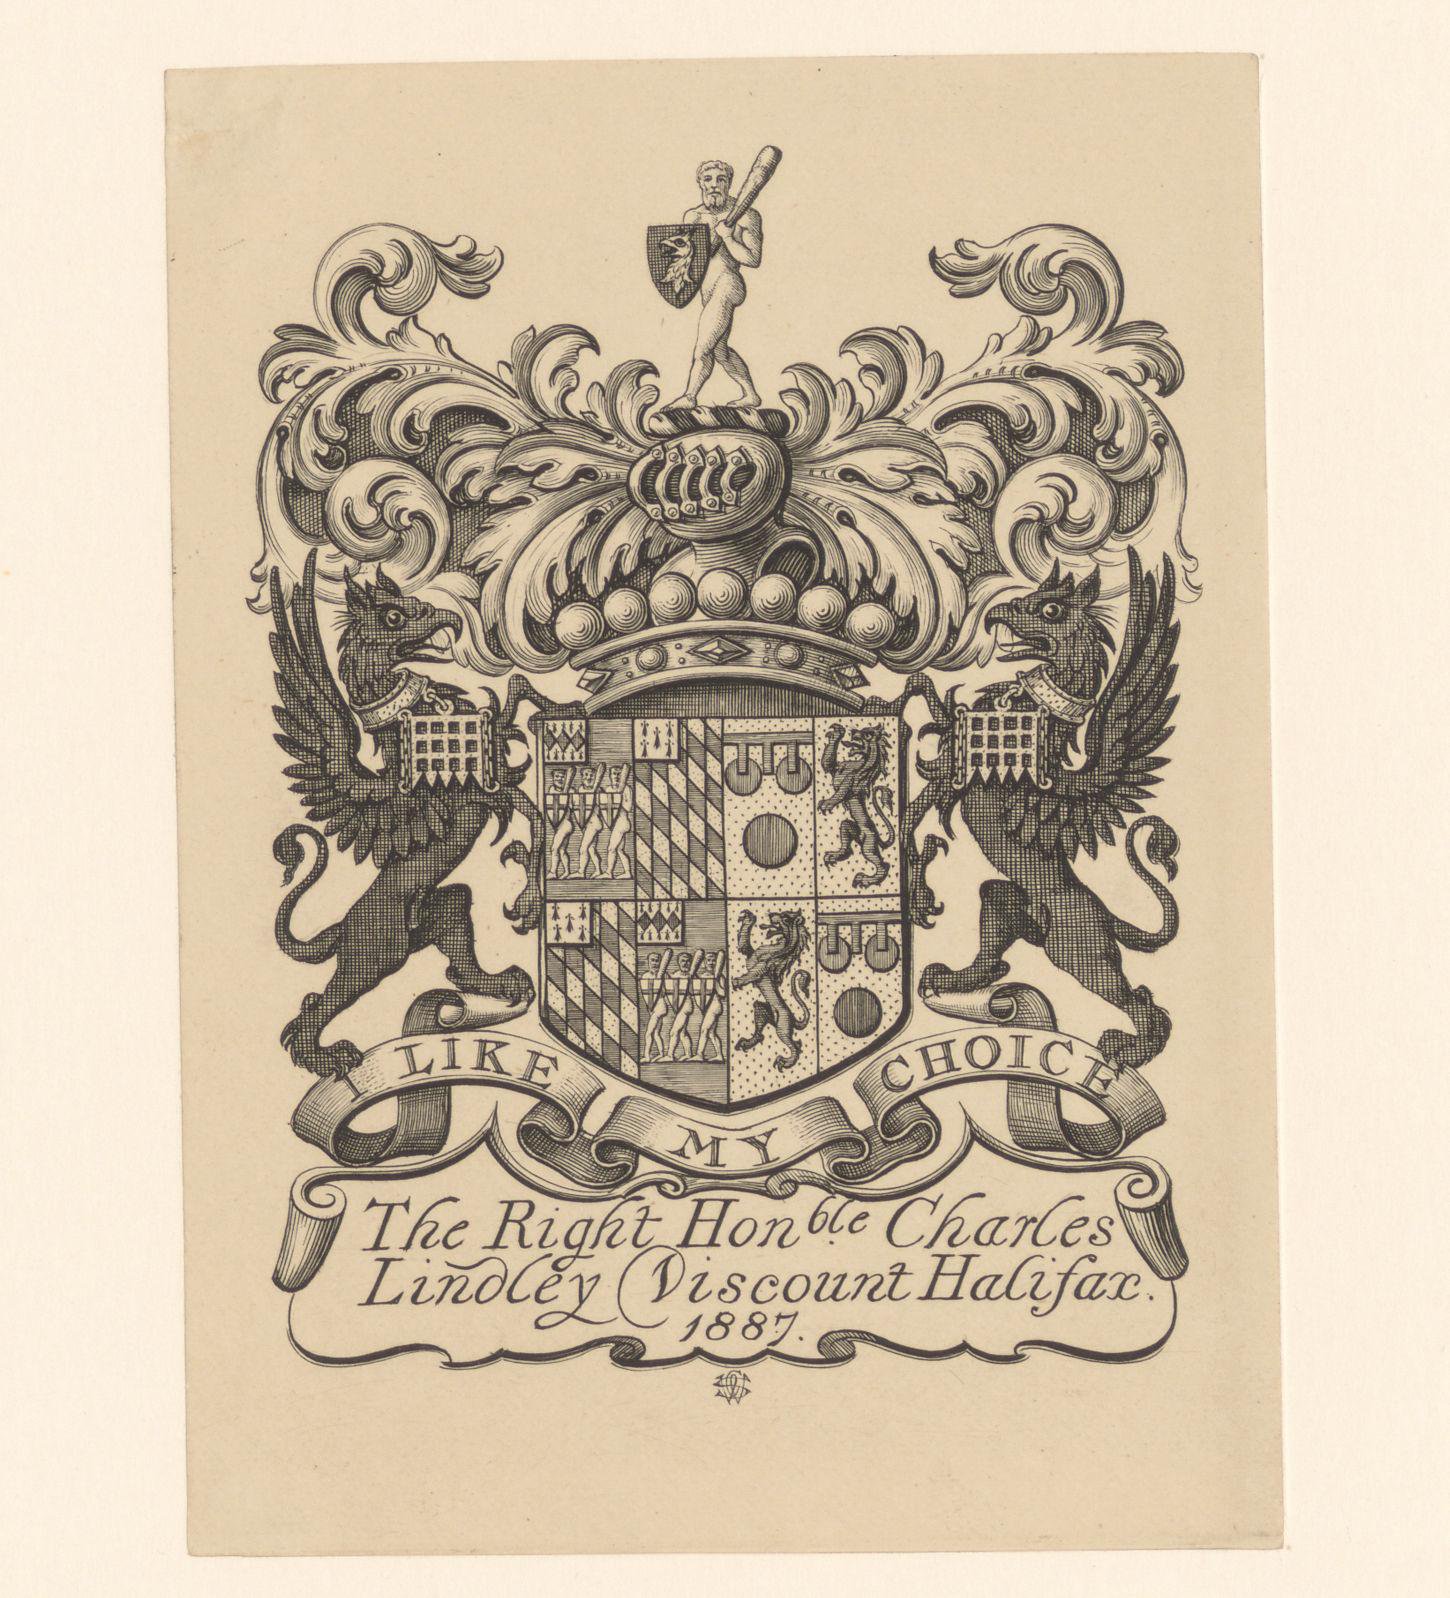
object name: bookplate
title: Ex libris van Charles Lindley Wood, burggraaf van Halifax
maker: charles william sherborn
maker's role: print maker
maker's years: 1831-1912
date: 1887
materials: paper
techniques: engraving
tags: foliage ~ ornament, siren (fabulous bird with woman's head), weapons for striking a blow: club, armorial bearing, heraldry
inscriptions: collector's mark: Lugt 2228